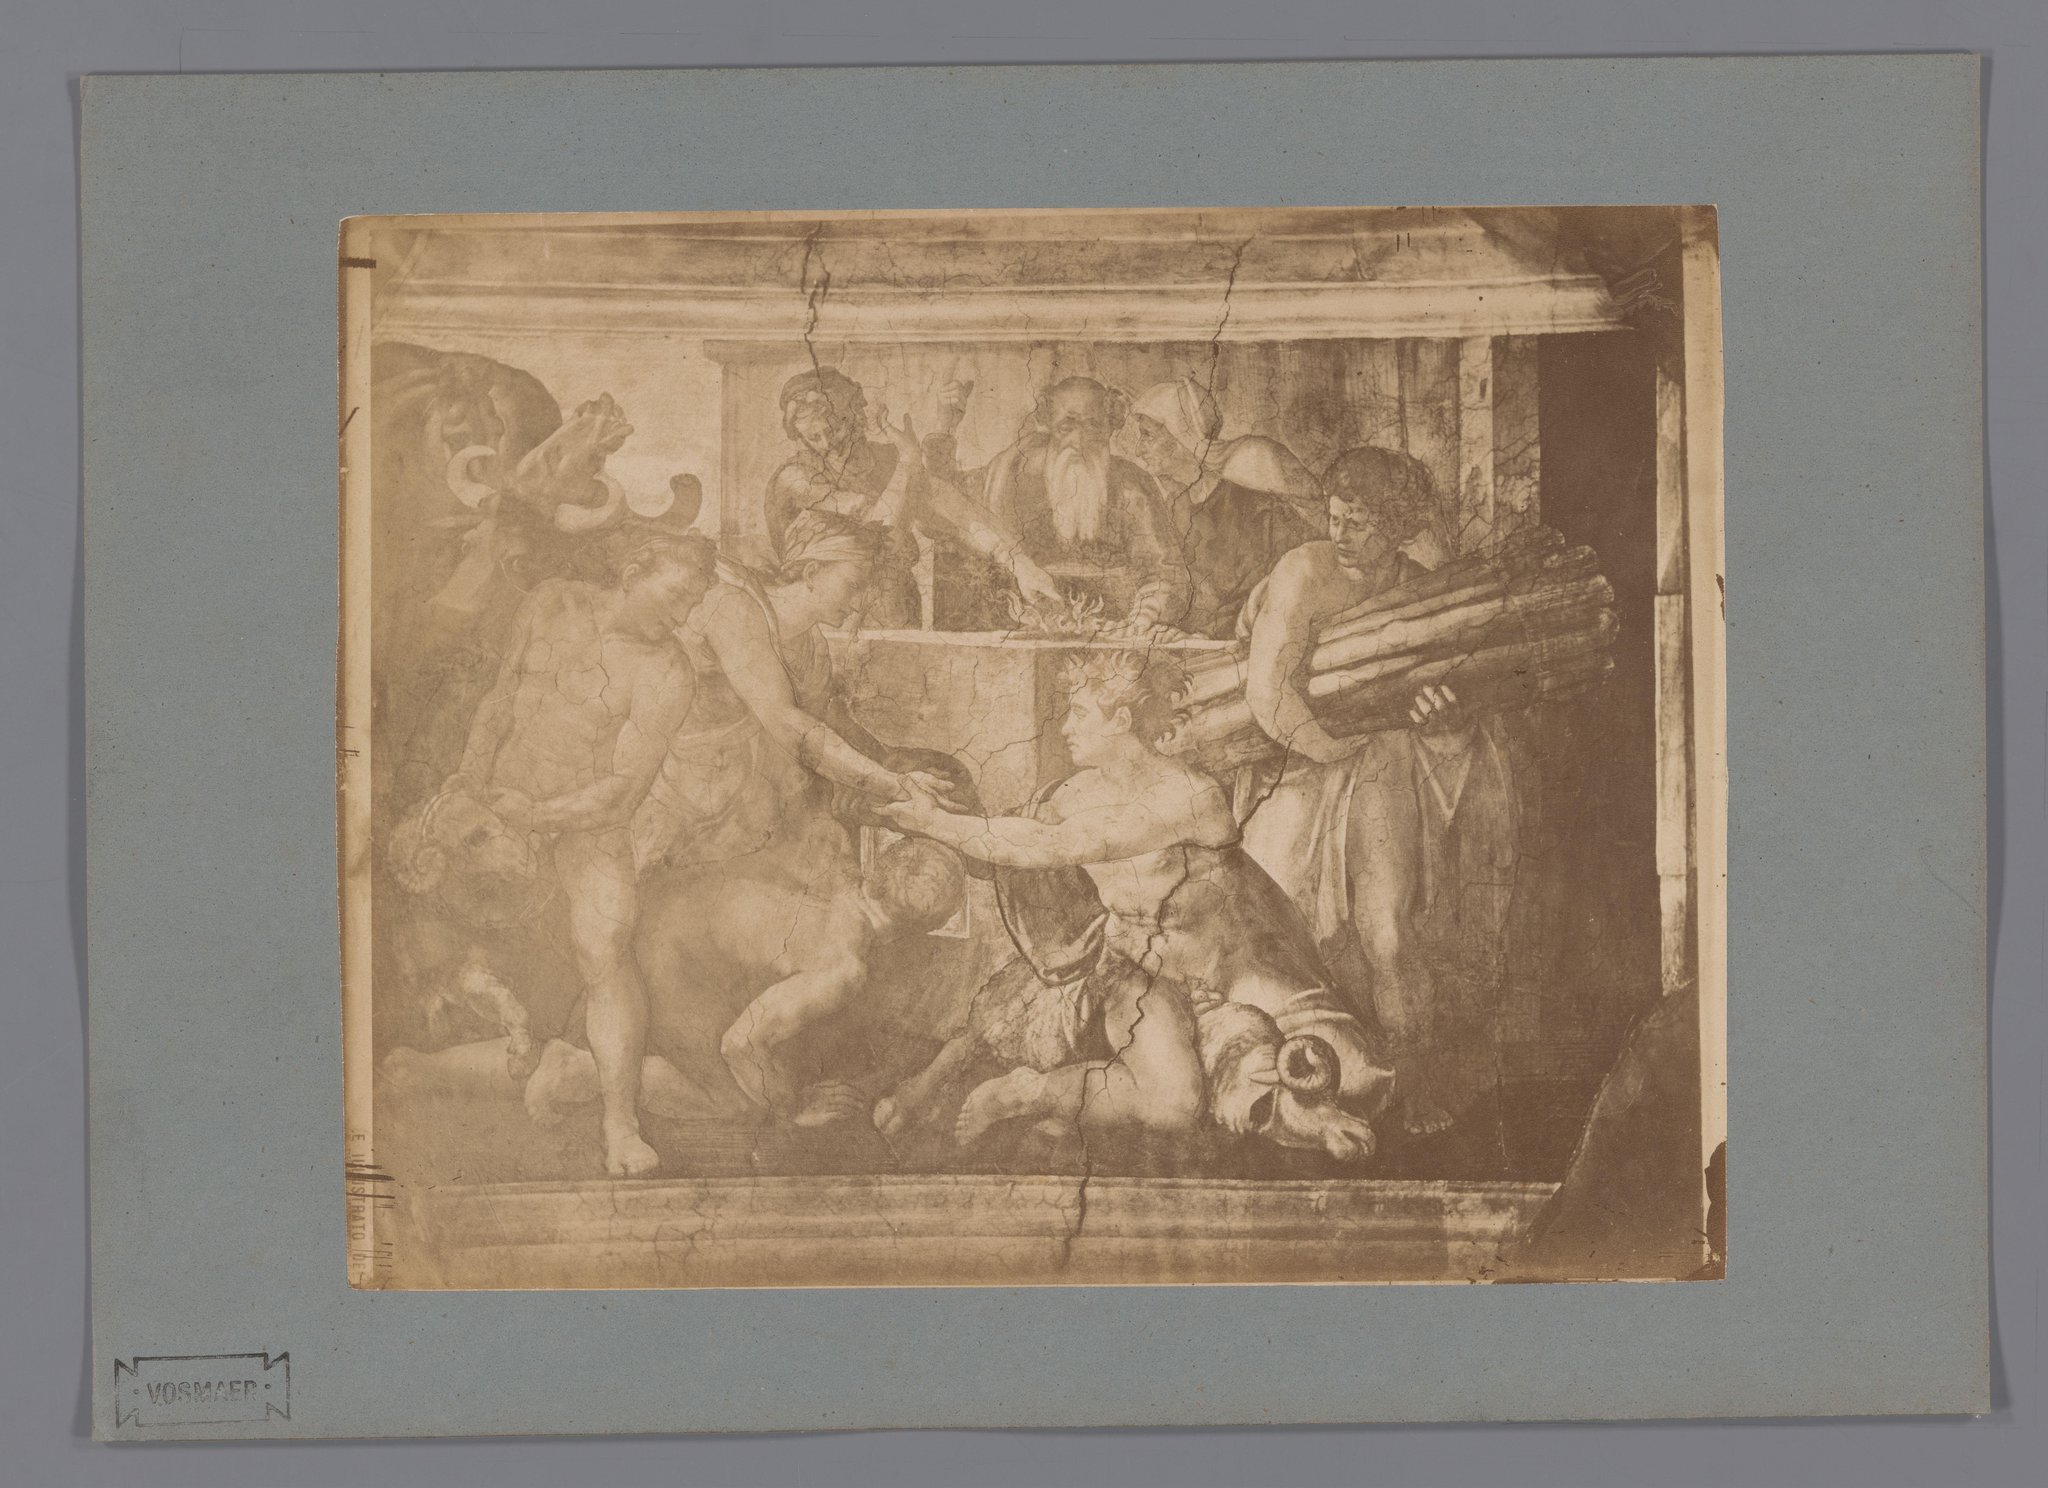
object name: reproduction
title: Fotoreproductie van het fresco Het offer van Noach door Michelangelo in de Sixtijnse kapel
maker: Anonymous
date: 1851-1900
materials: cardboard, paper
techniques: albumen print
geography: vatican city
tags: picture, painting, noah's sacrifice; various animals are offered, possibly a lamb, a dove and a ram (often combined with the rainbow of the covenant), wall-covering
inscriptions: collector's mark: ‘VOSMAER’